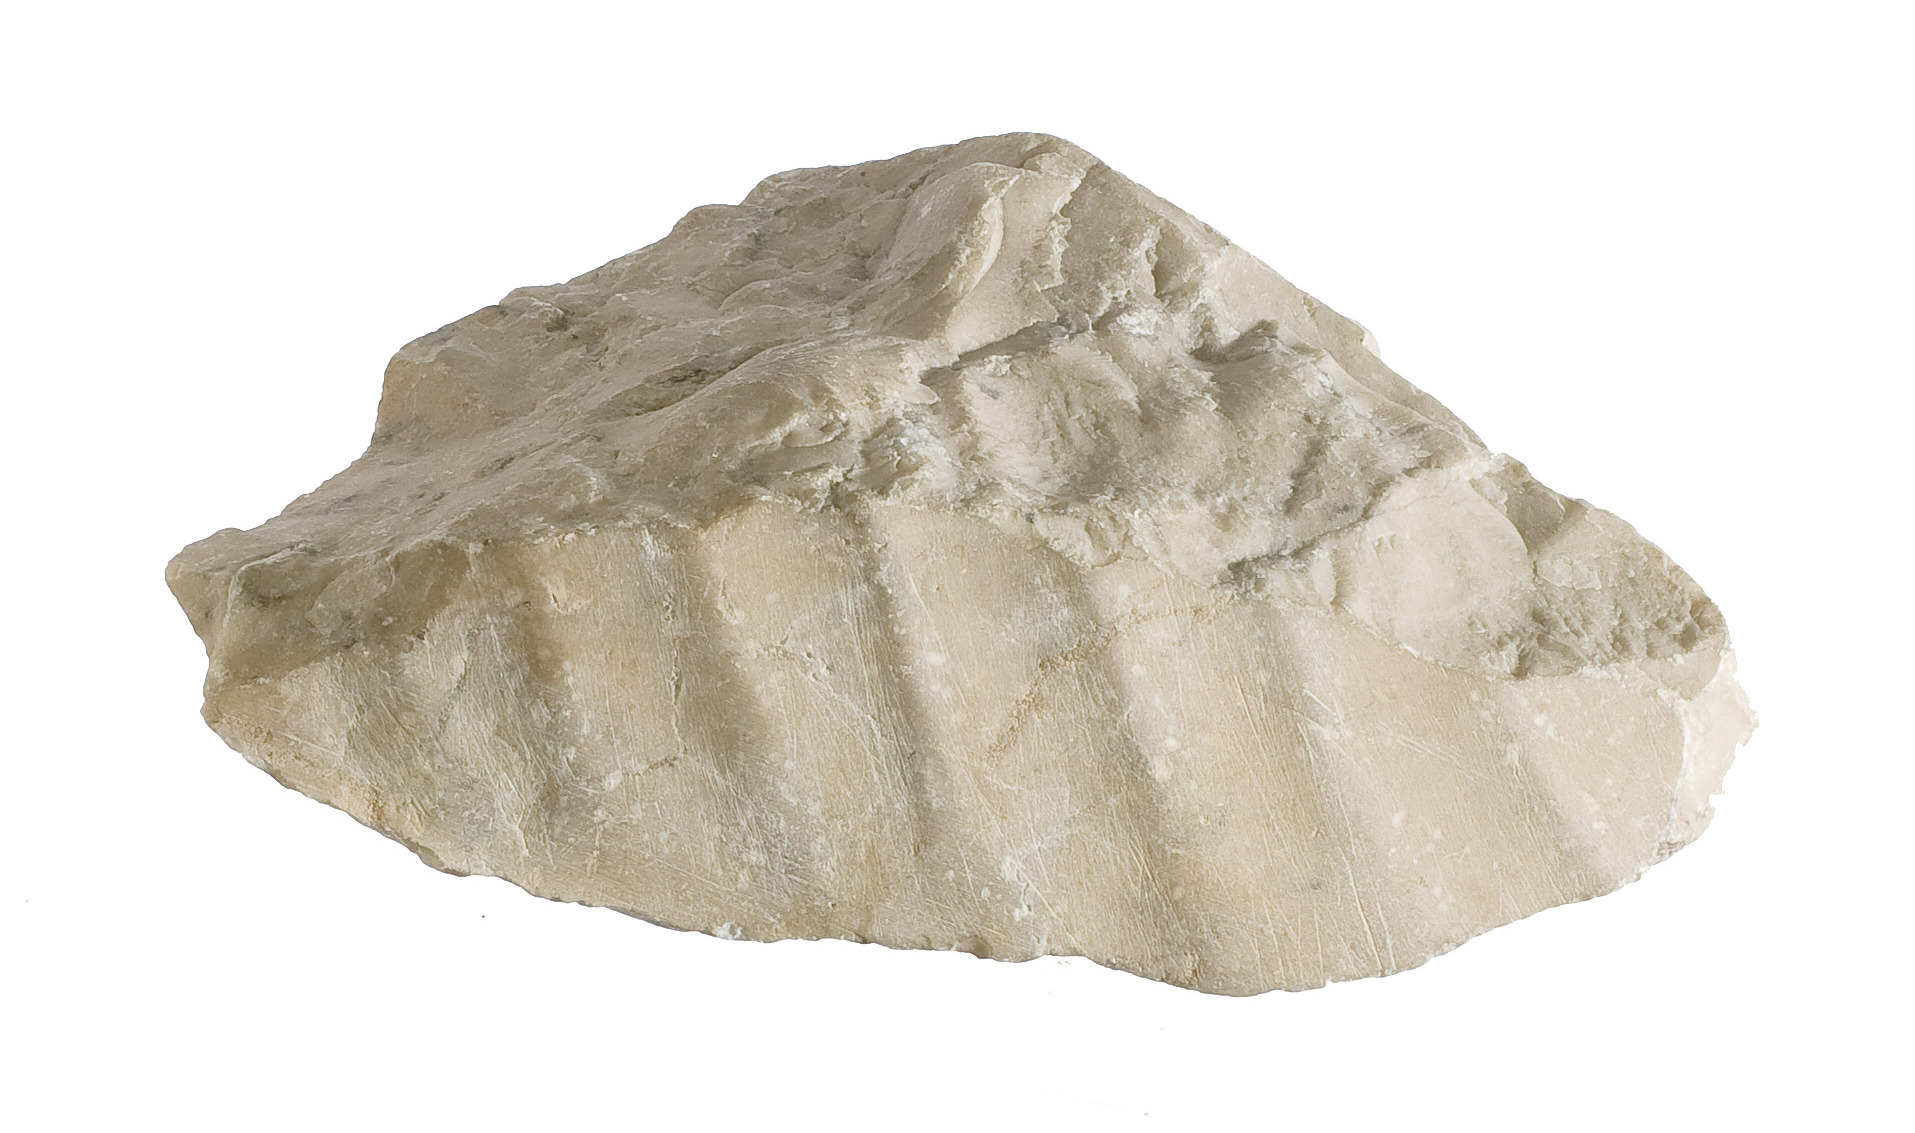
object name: body with garment, pleating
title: Body, with pleated garment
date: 1353-1336 BCE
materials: limestone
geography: egypt